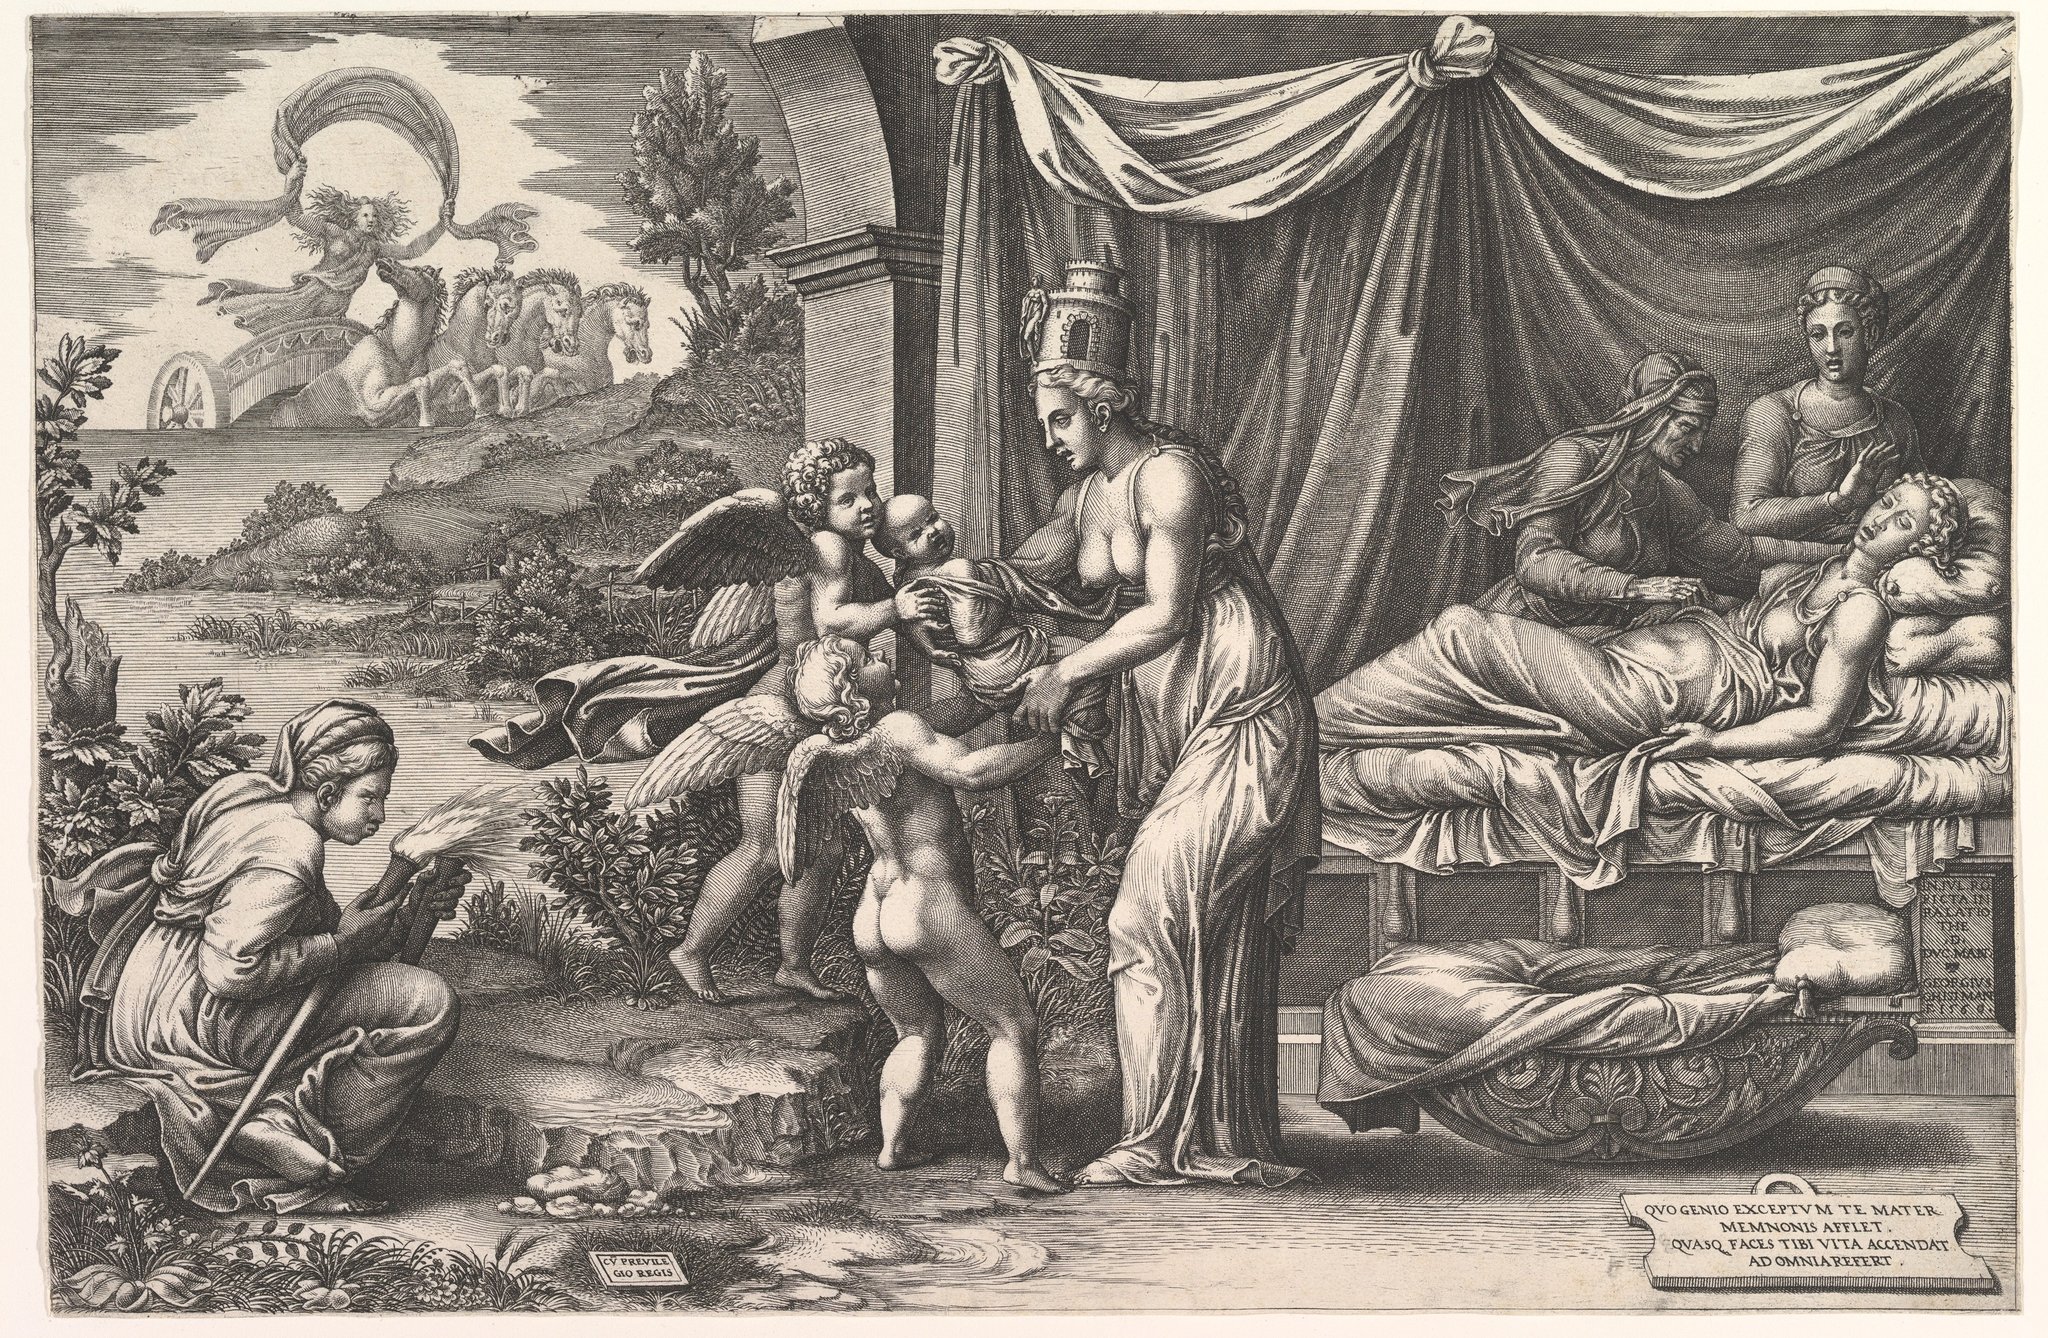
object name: print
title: Allegory of Birth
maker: giorgio ghisi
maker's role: artist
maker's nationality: italian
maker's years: 1515-1582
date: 1558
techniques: engraving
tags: infants,women,birth,carriages